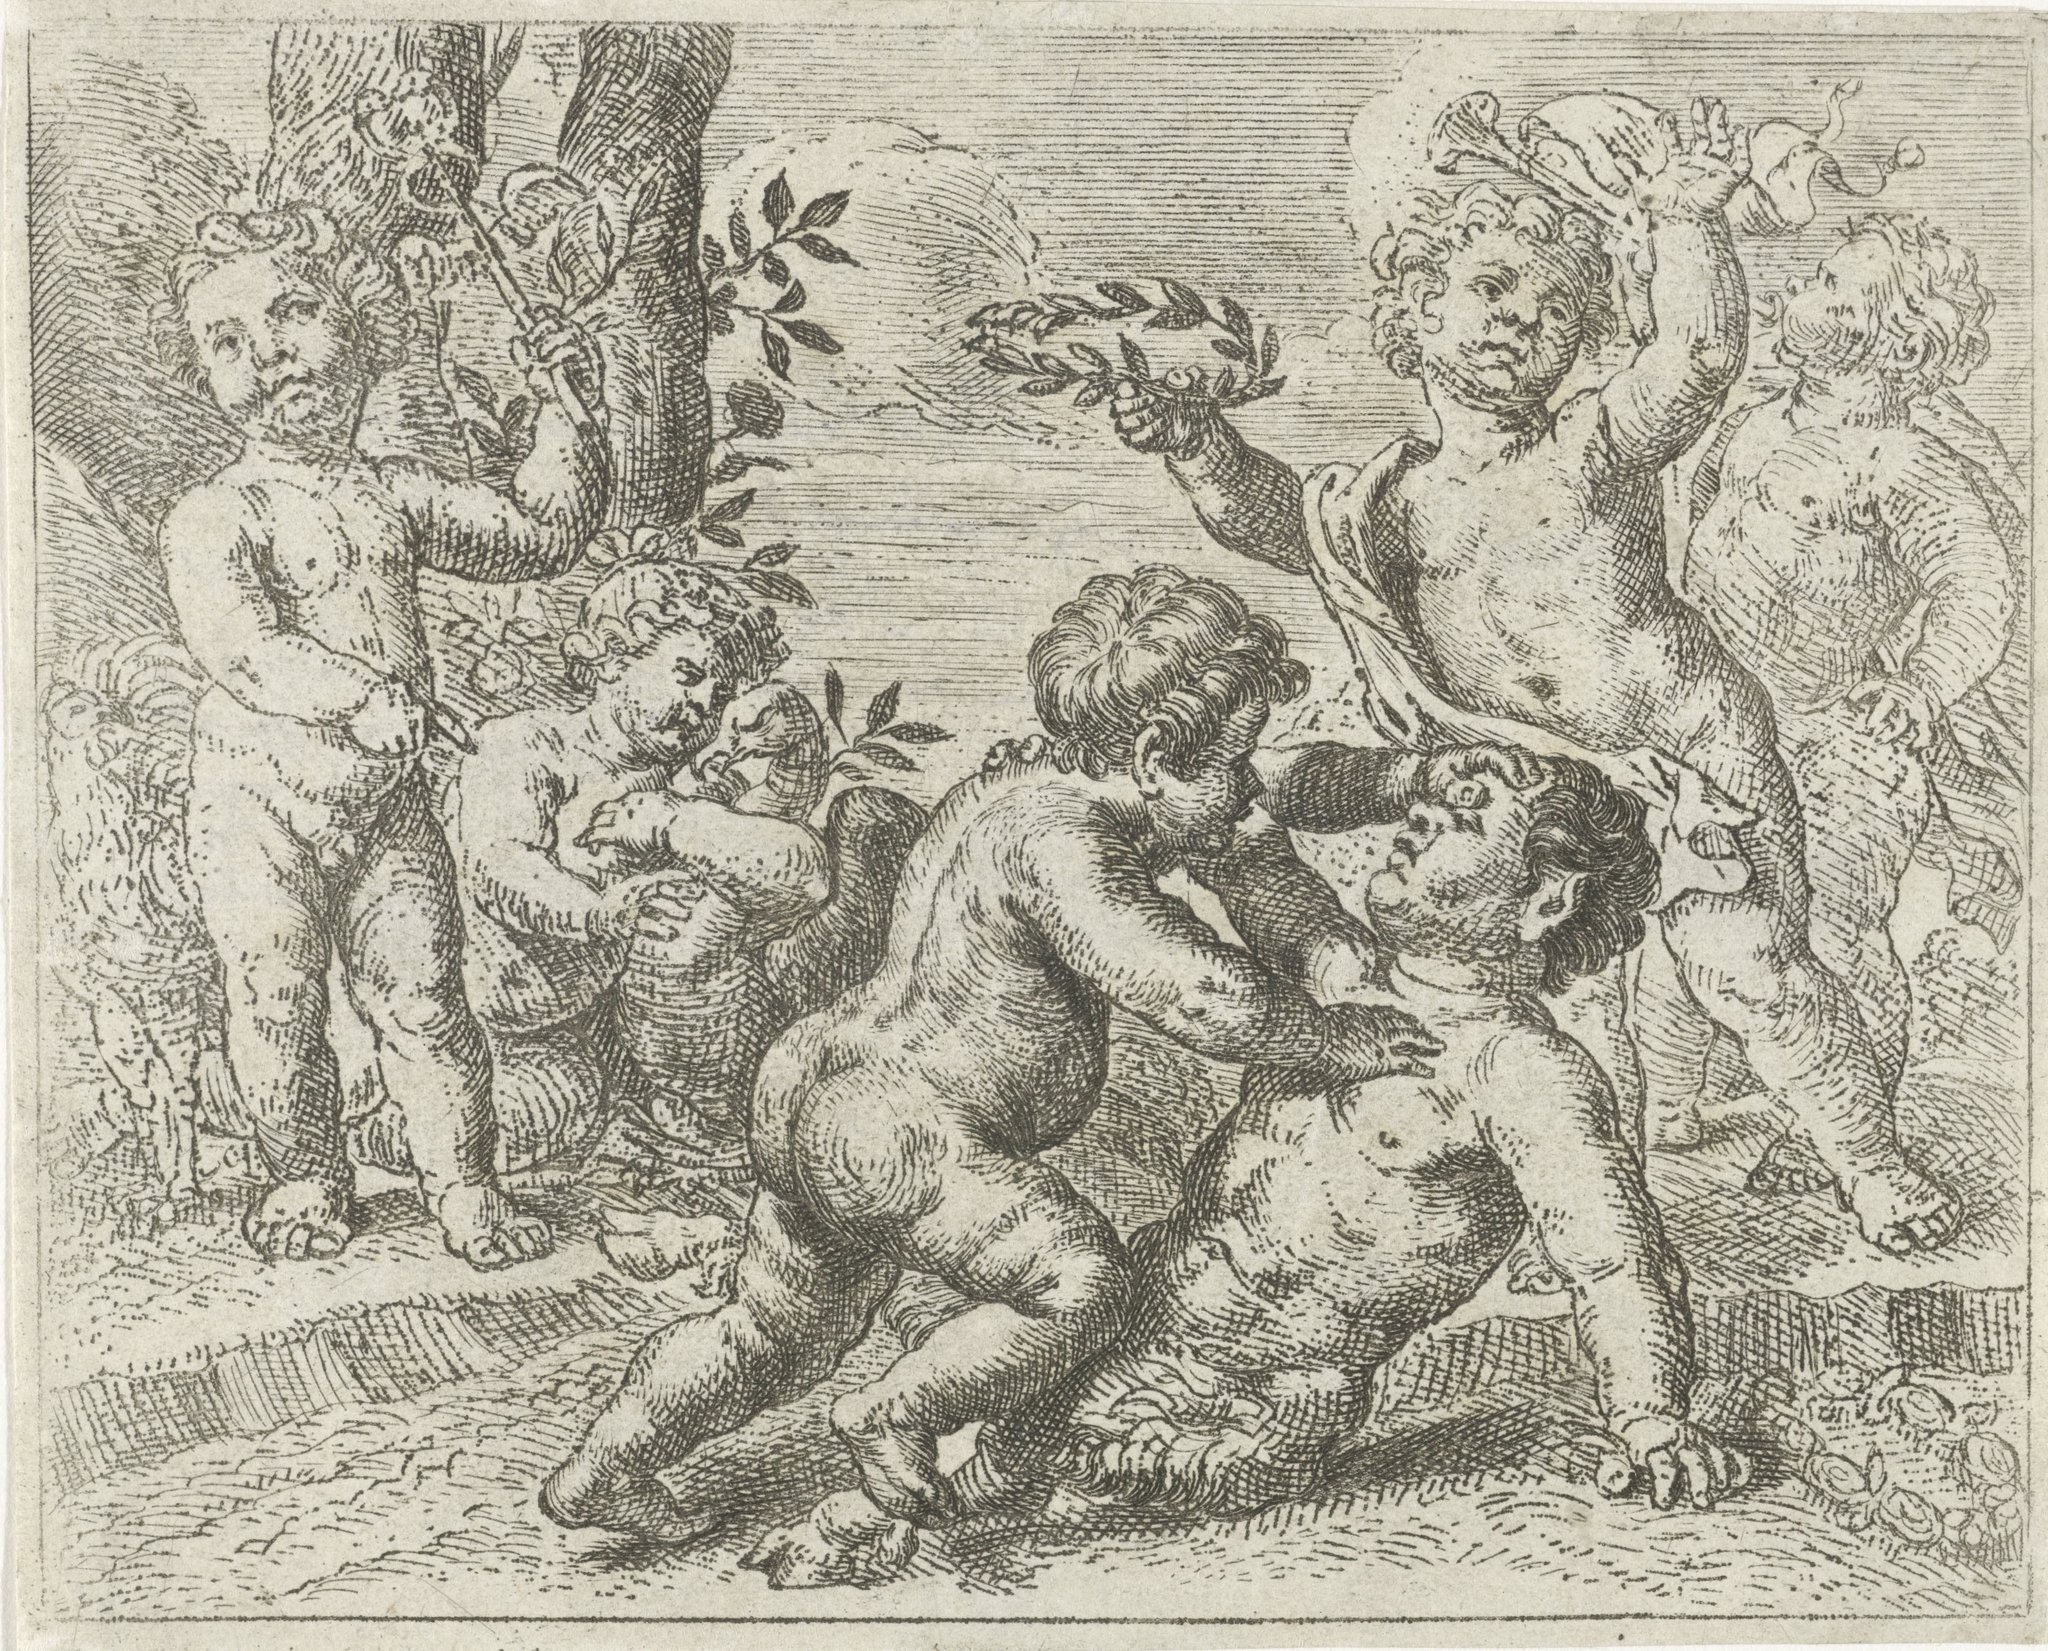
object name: print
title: Vechtende putti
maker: peter van lint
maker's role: draughtsman, painter, print maker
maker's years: 1609-1690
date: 1619-1690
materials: paper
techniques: etching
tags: figure representing a virtue vs. a vice, cupids: 'amores', 'amoretti', 'putti'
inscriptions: collector's mark: Lugt 2228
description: Twee vechtende putti op de voorgrond symboliseren de strijd tussen de deugd en de ondeugd. Rechts staat een putto met lauwerkrans klaar voor de overwinnaar, links kijkt een putto met caduceus toe. Op de achtergrond blaast een putto de bazuin, een andere putto houdt een vogel in zijn armen.